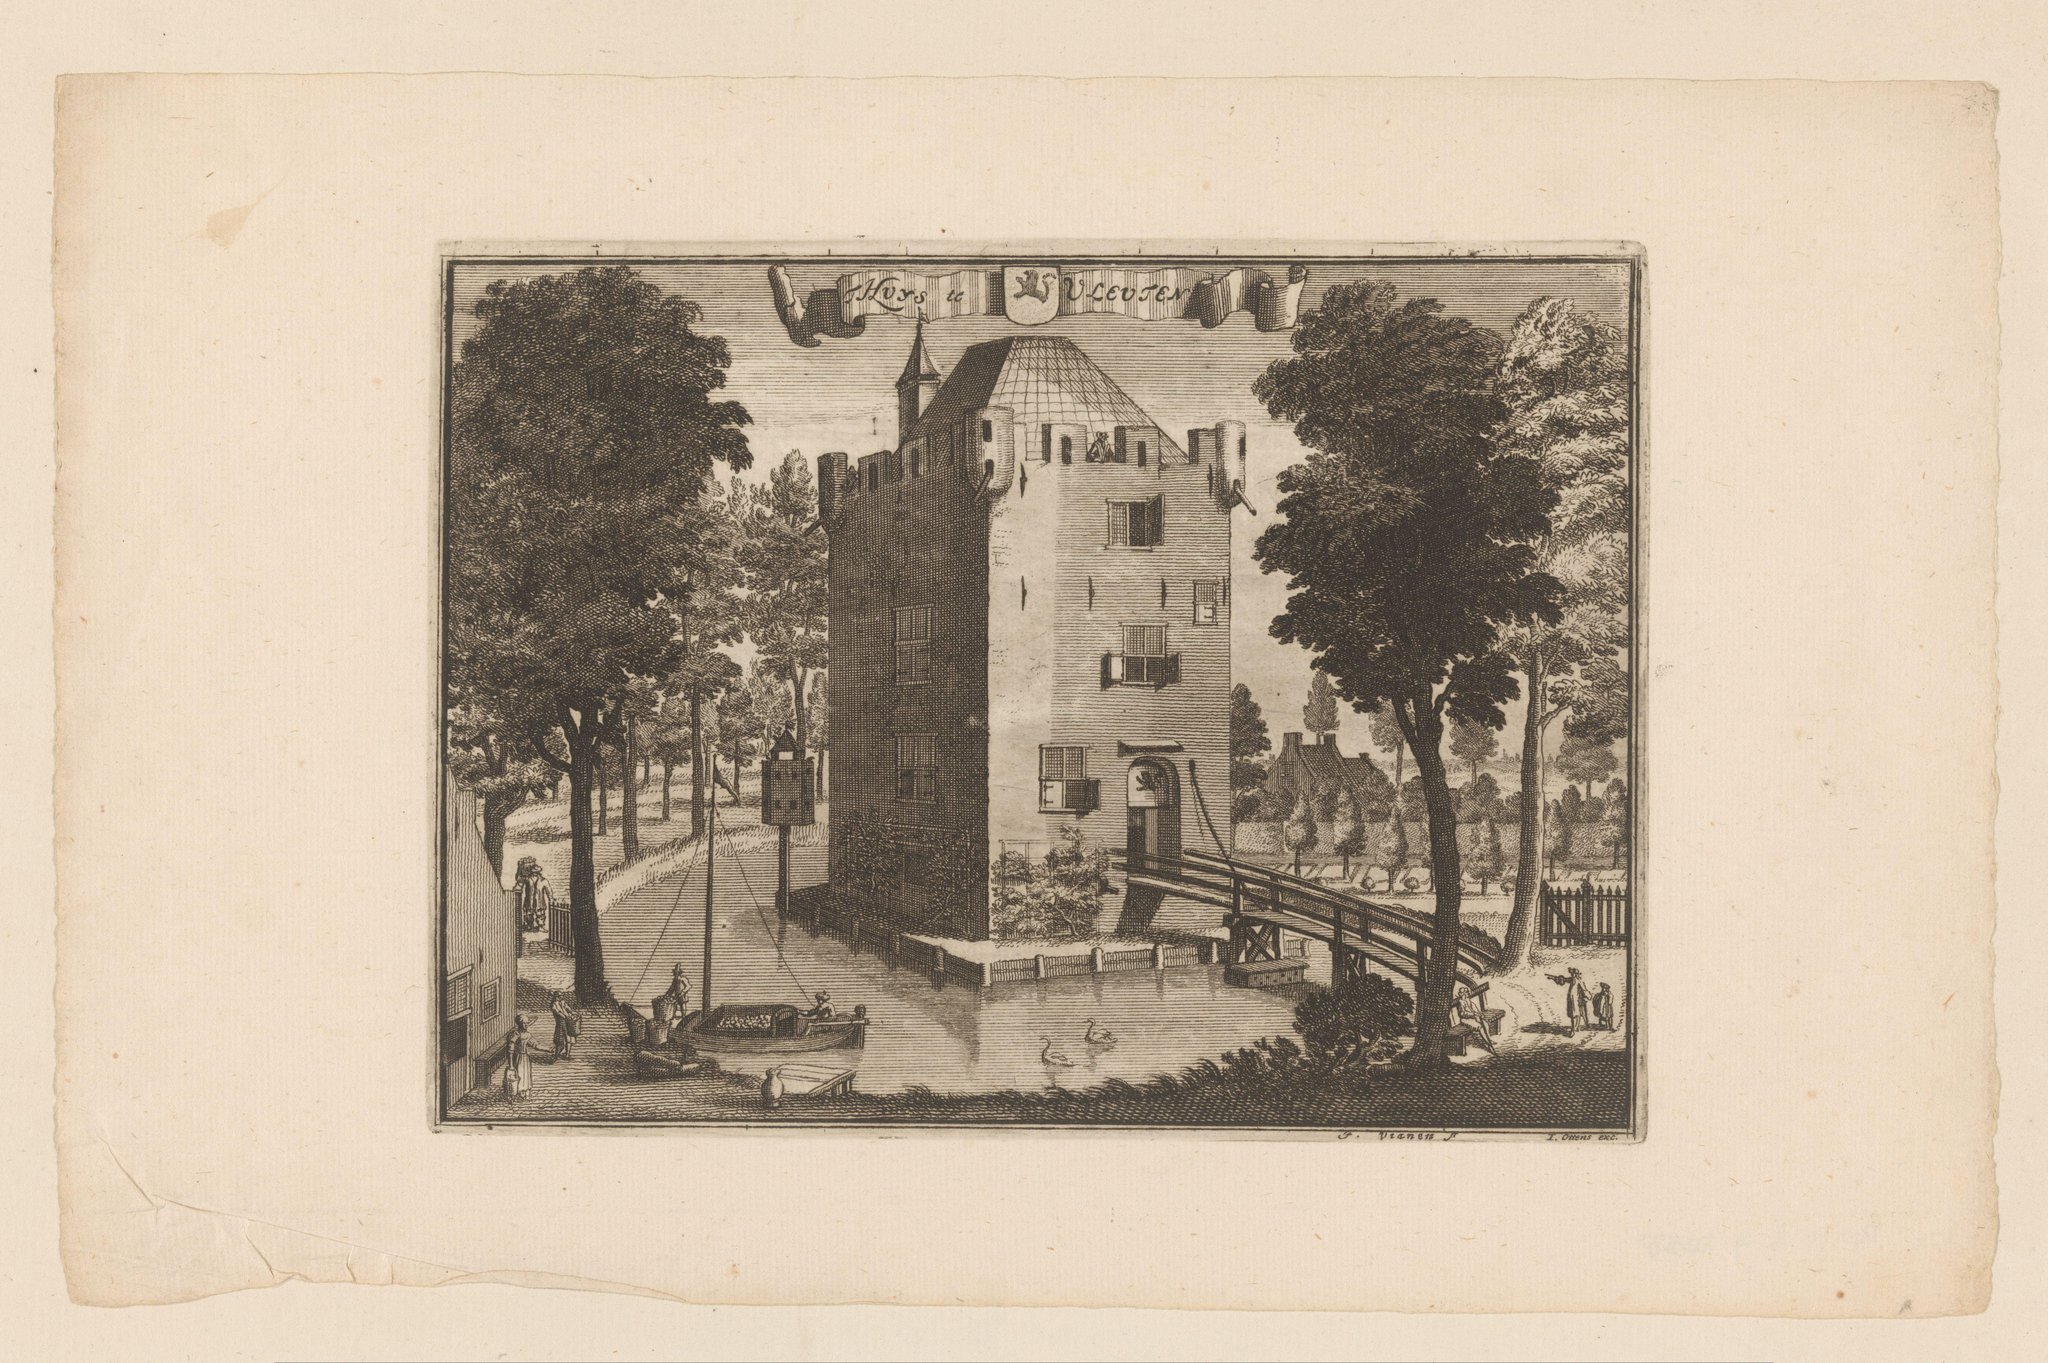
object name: print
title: 't Huys te Vleuten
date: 1710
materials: paper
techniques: engraving, etching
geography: utrecht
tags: castle, landscape with tower or castle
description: Prent uit: De Ridder-matige Huysen en Gesichten in de Provincie van Utrecht. Amsterdam: Joachim Ottens, [ca. 1710].